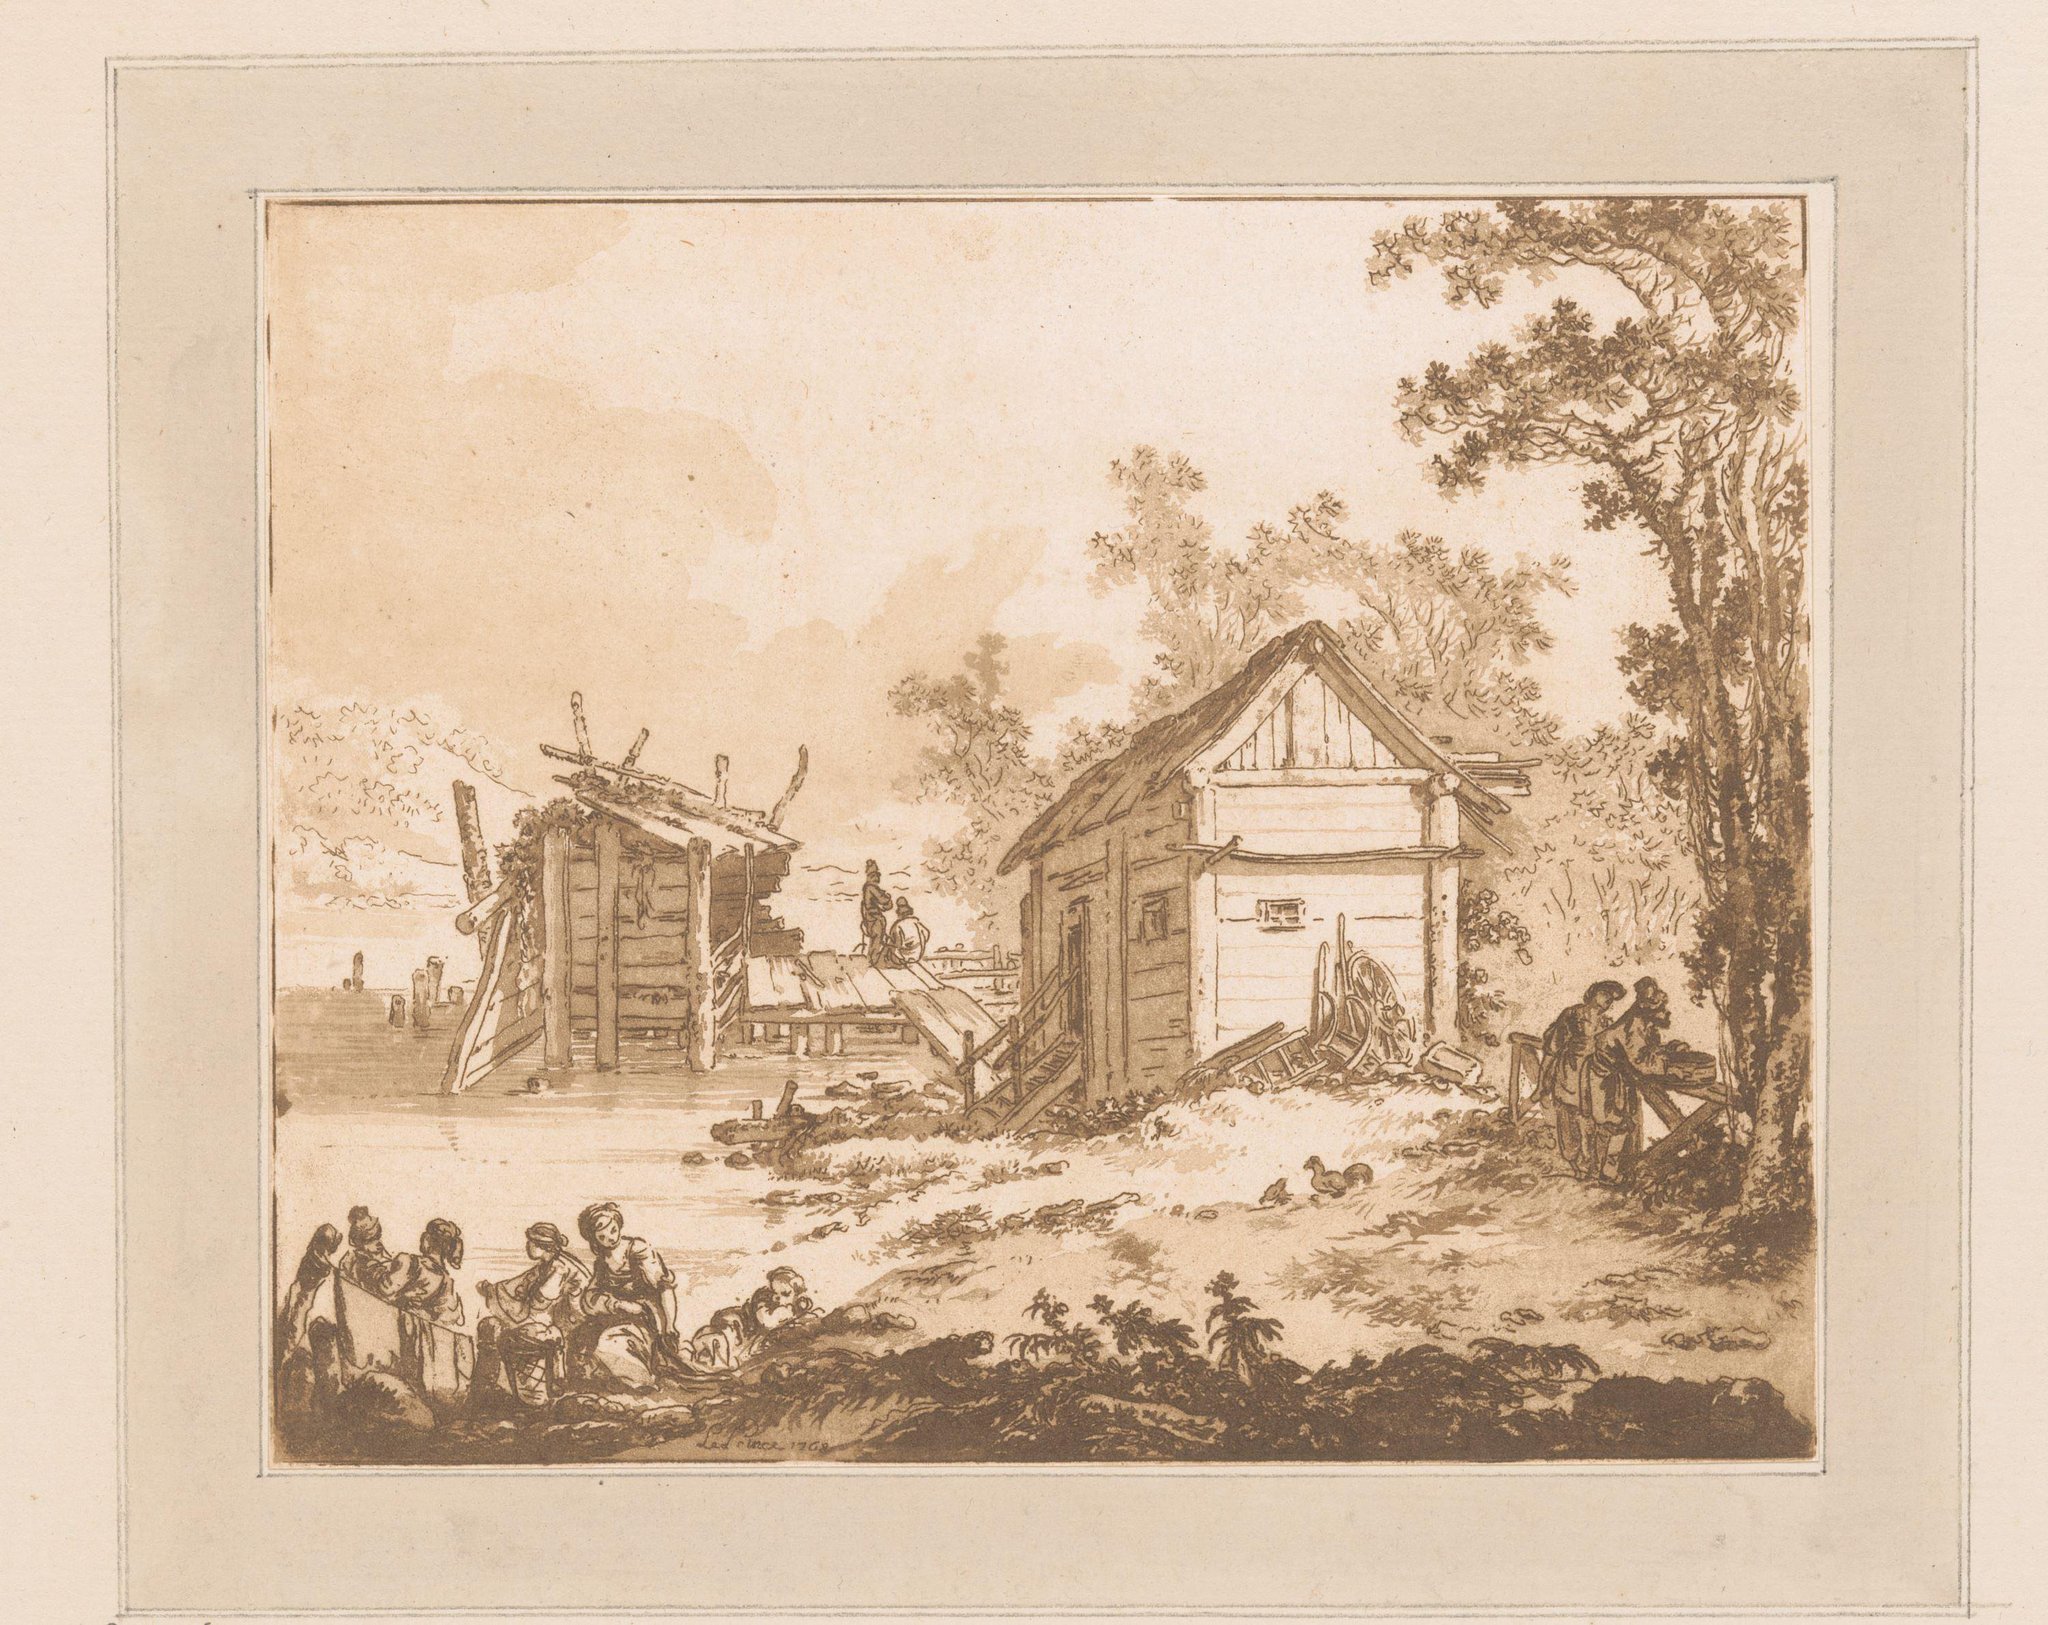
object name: print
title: Twee hutten aan een steiger met vissers en andere figuren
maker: jean baptist leprince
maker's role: draughtsman, print maker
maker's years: 1734-1781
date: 1768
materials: paper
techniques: aquatint, etching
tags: civic architecture; edifices; dwellings, fisherman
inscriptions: date